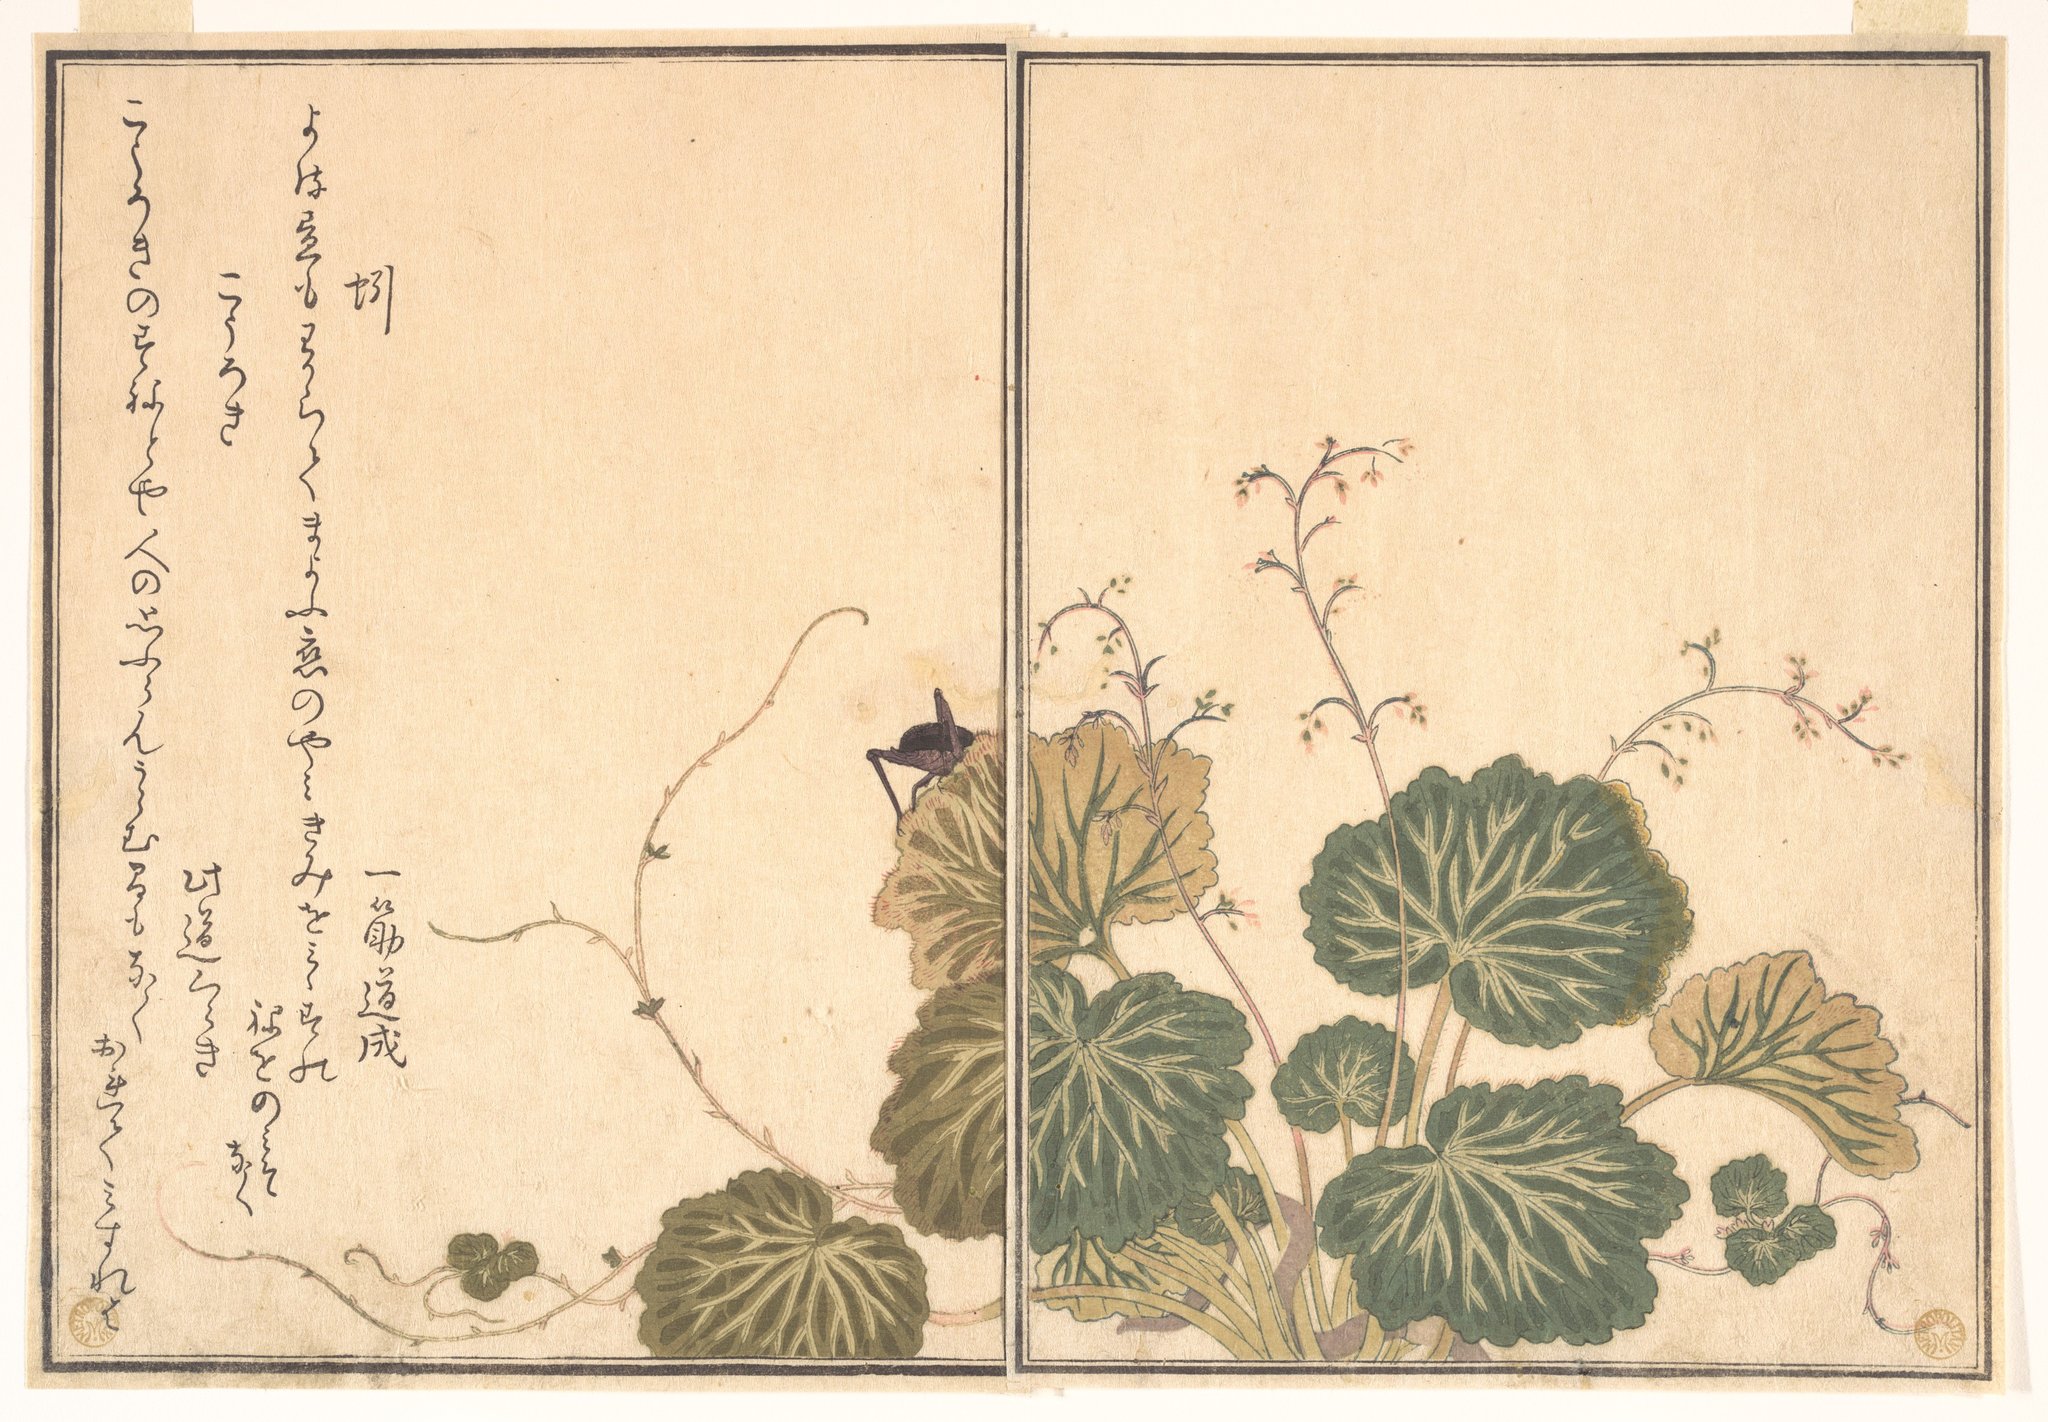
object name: woodblock print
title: Earthworm (Mimizu); Cricket (Kōrogi), from the Picture Book of Crawling Creatures (Ehon mushi erami)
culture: japanese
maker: kitagawa utamaro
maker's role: artist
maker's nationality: japanese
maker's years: 1754-1806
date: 1788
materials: ink, paper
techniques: woodblock print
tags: insects